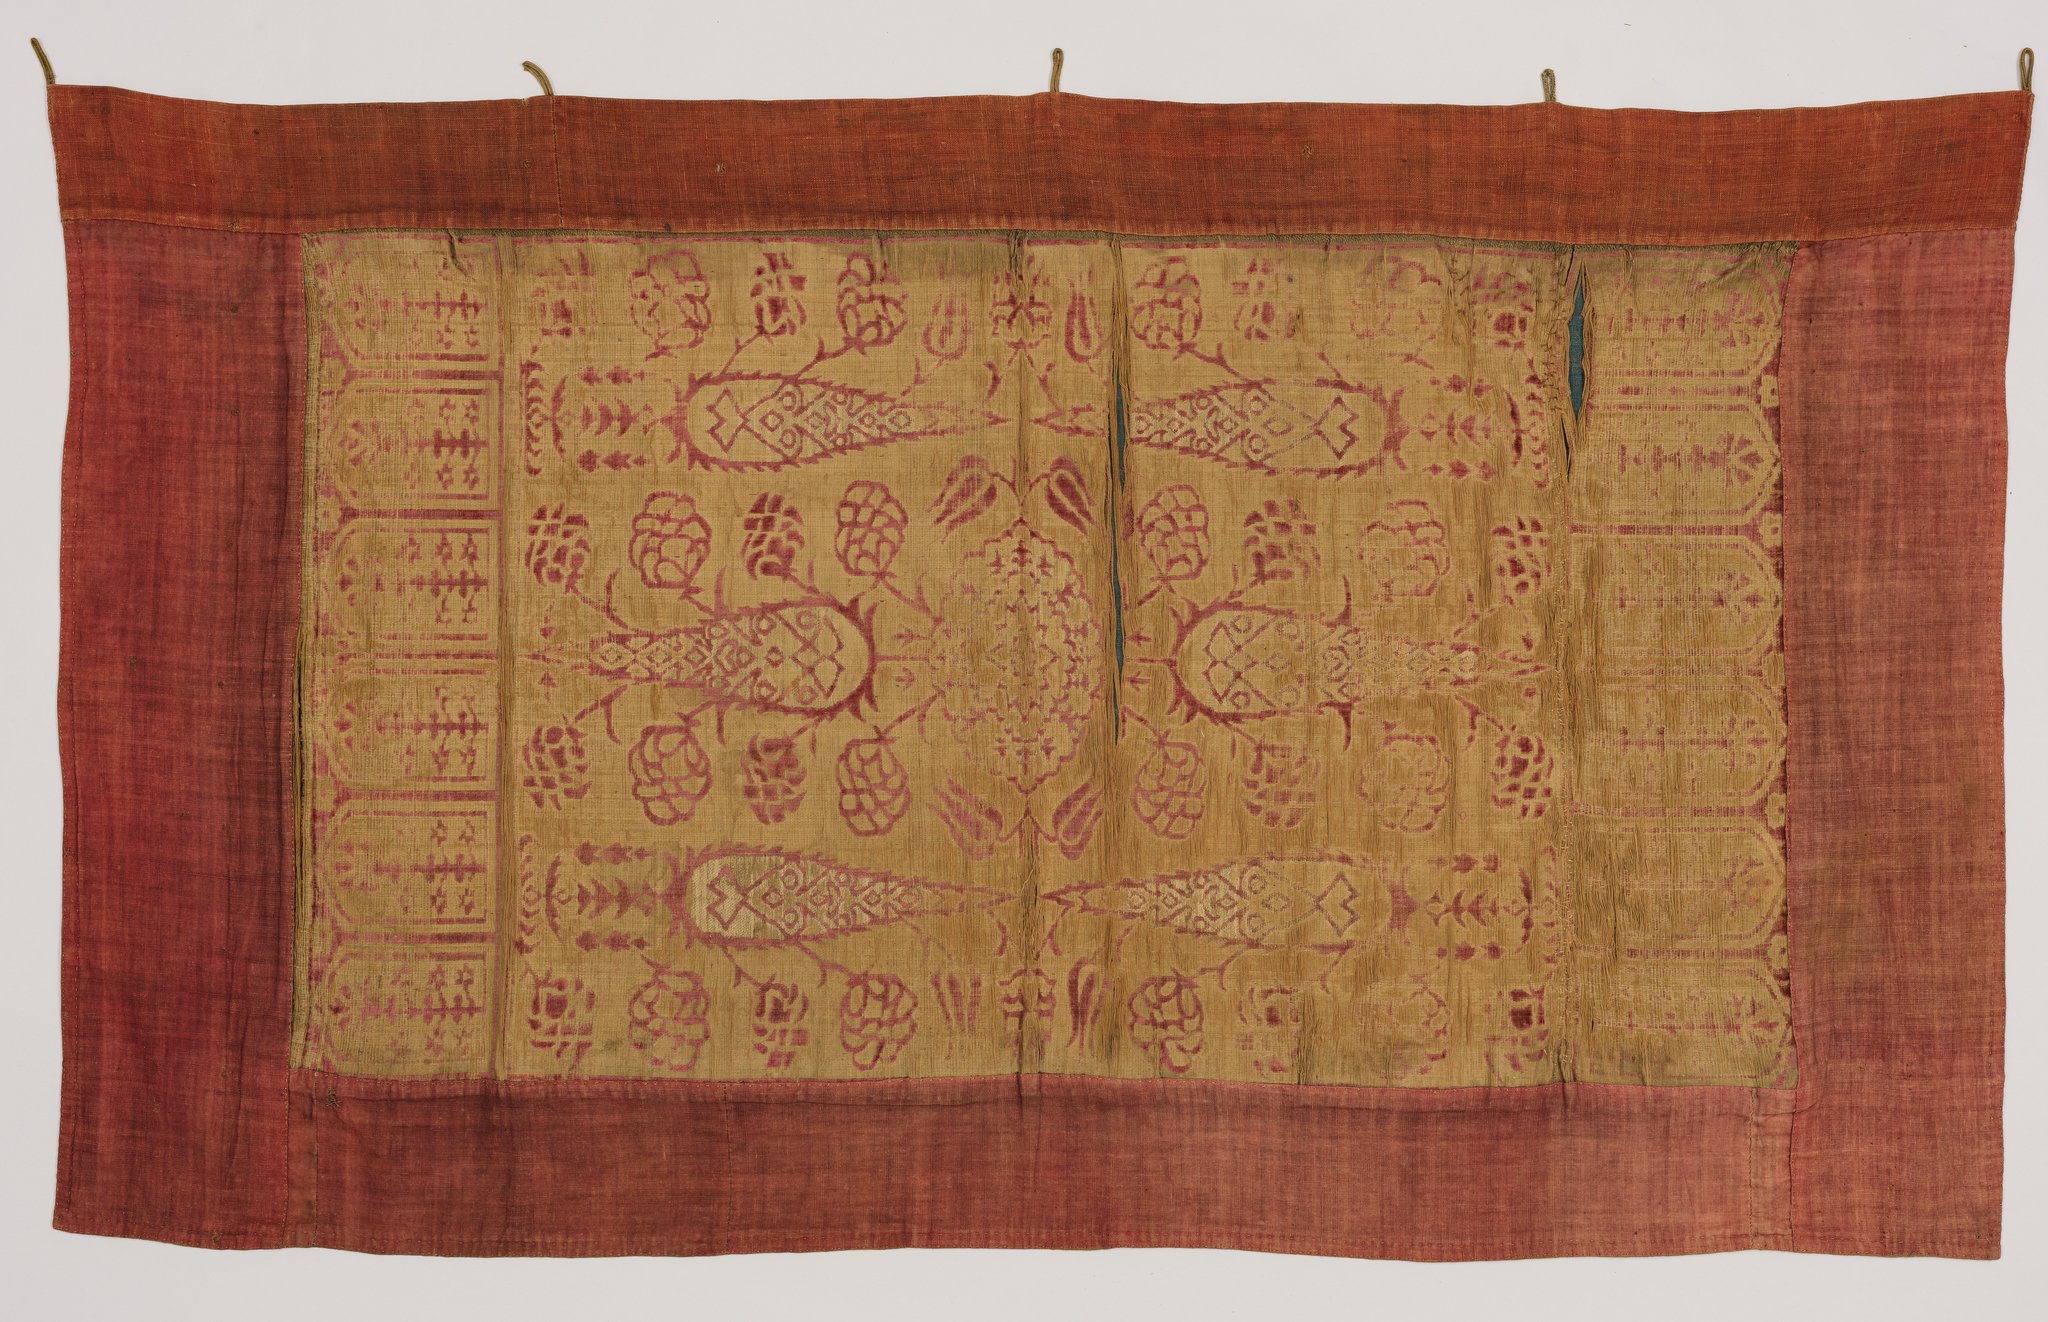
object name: cushion cover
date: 1701-1800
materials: cotton, silk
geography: turkey